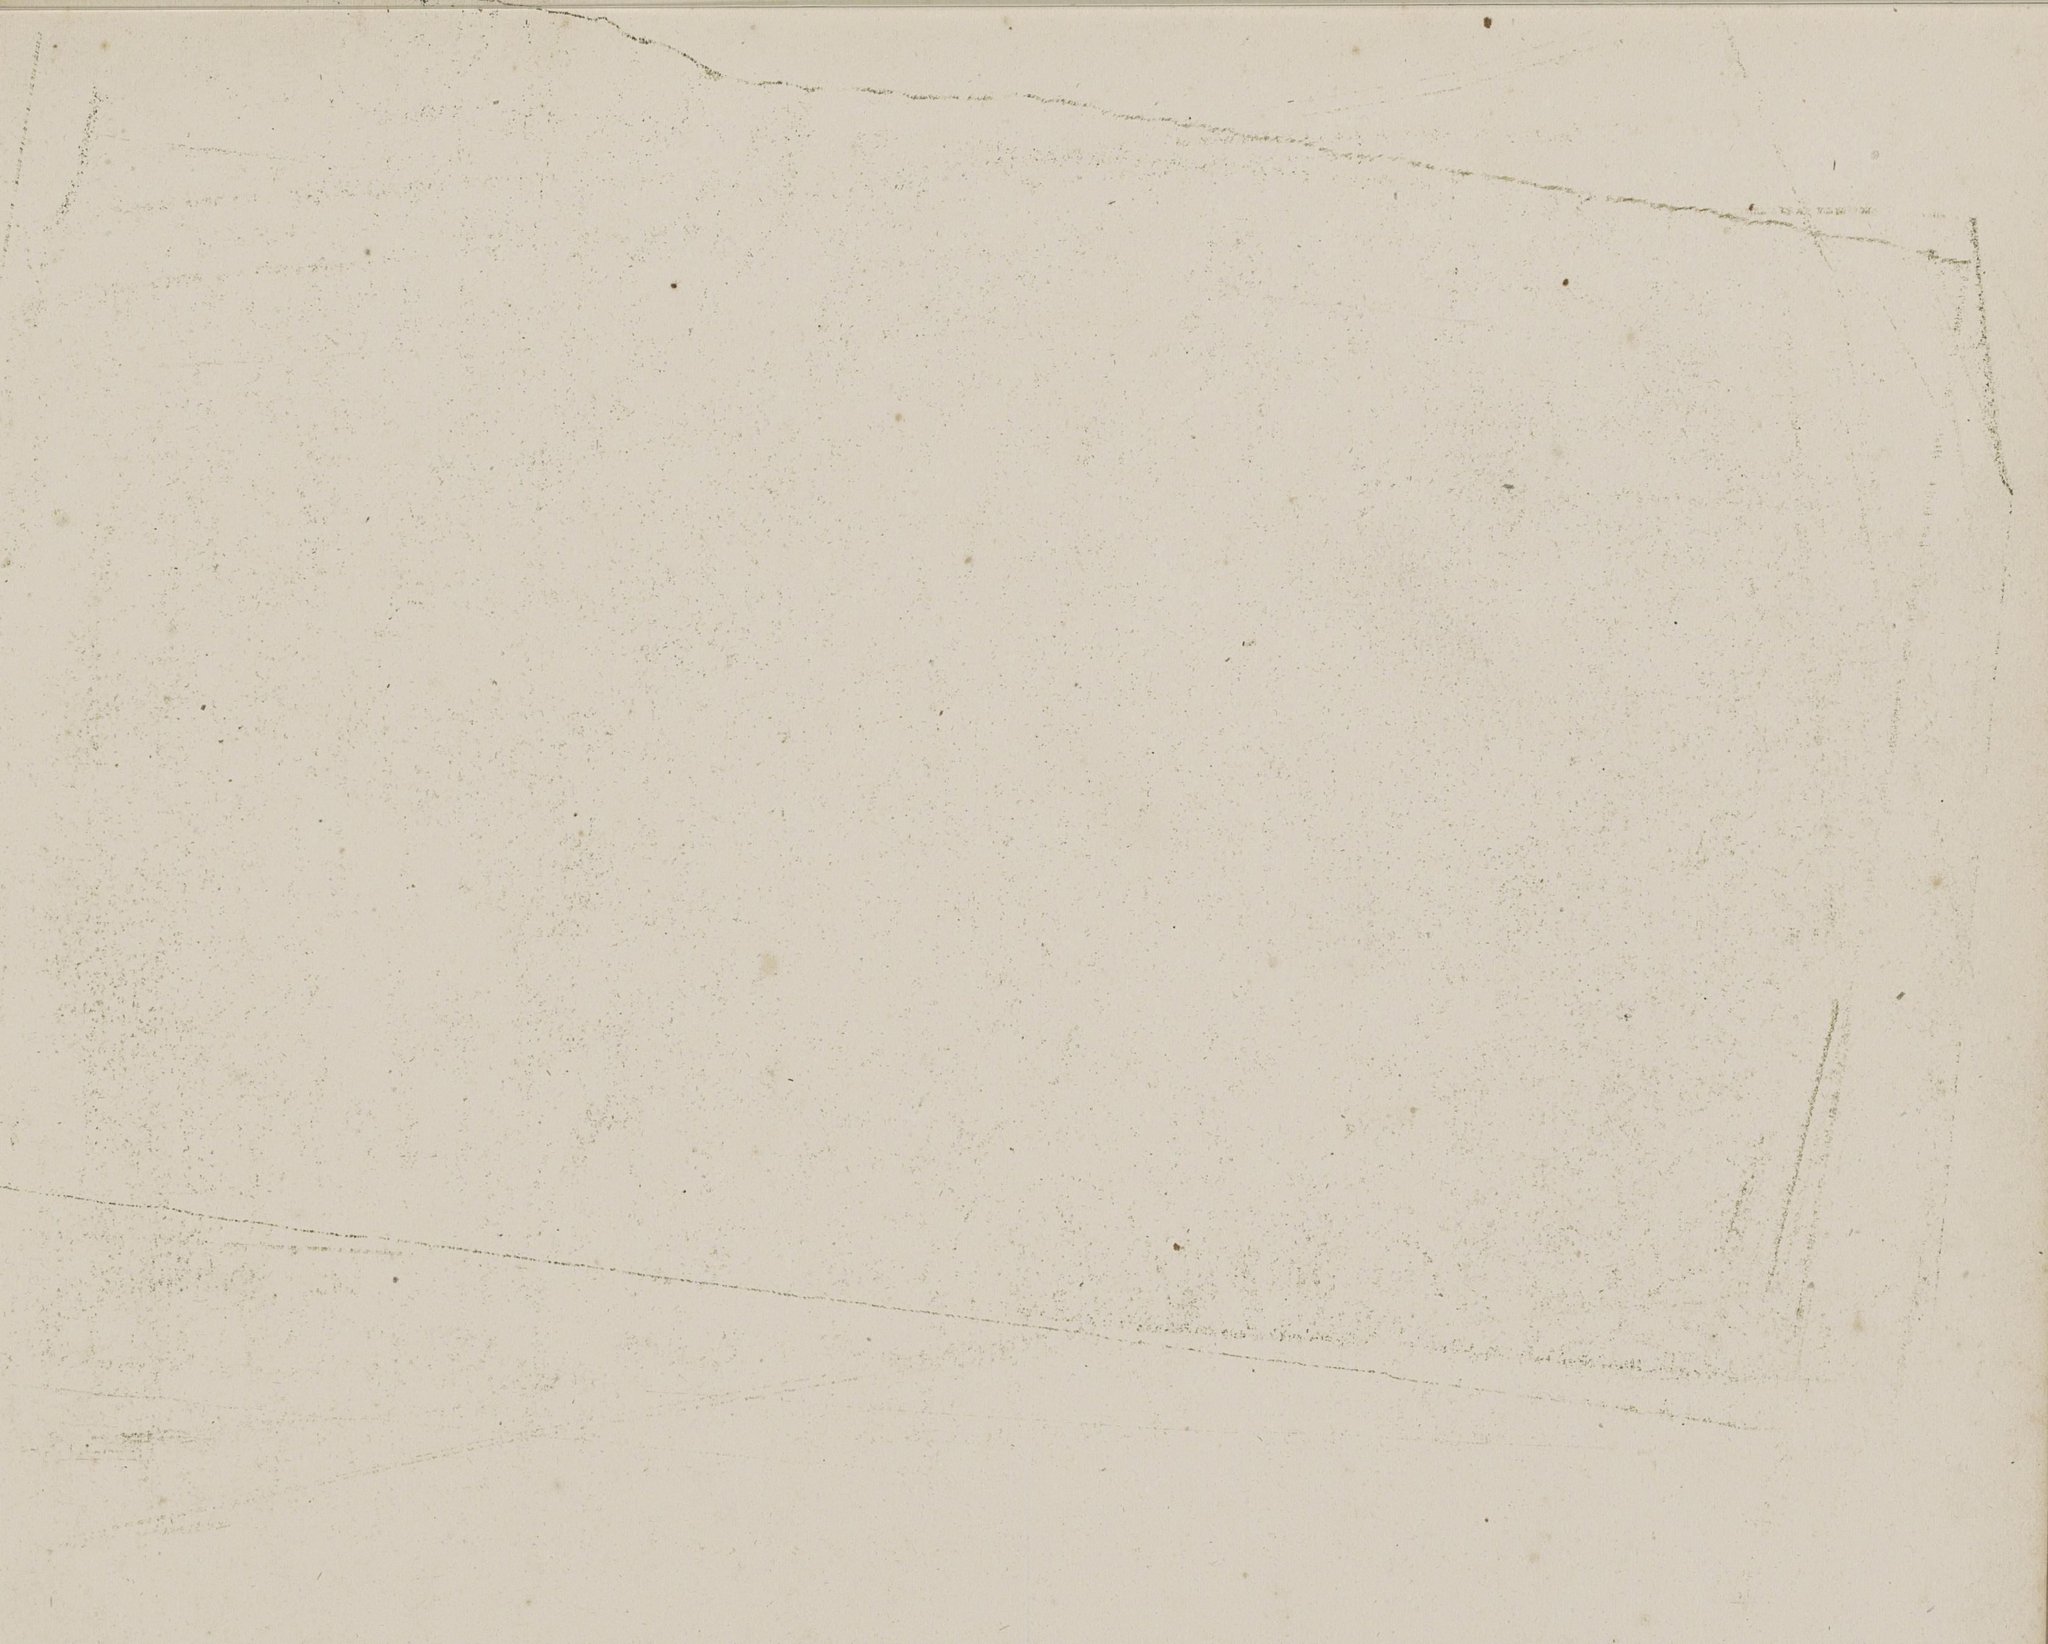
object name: sketchbook leaf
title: Abklatsch van een krijttekening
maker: gerrit postma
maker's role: draughtsman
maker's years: 1819-1894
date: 1829-1894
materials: paper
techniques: printmaking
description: Blad 6 recto uit een schetsboek met 35 bladen.